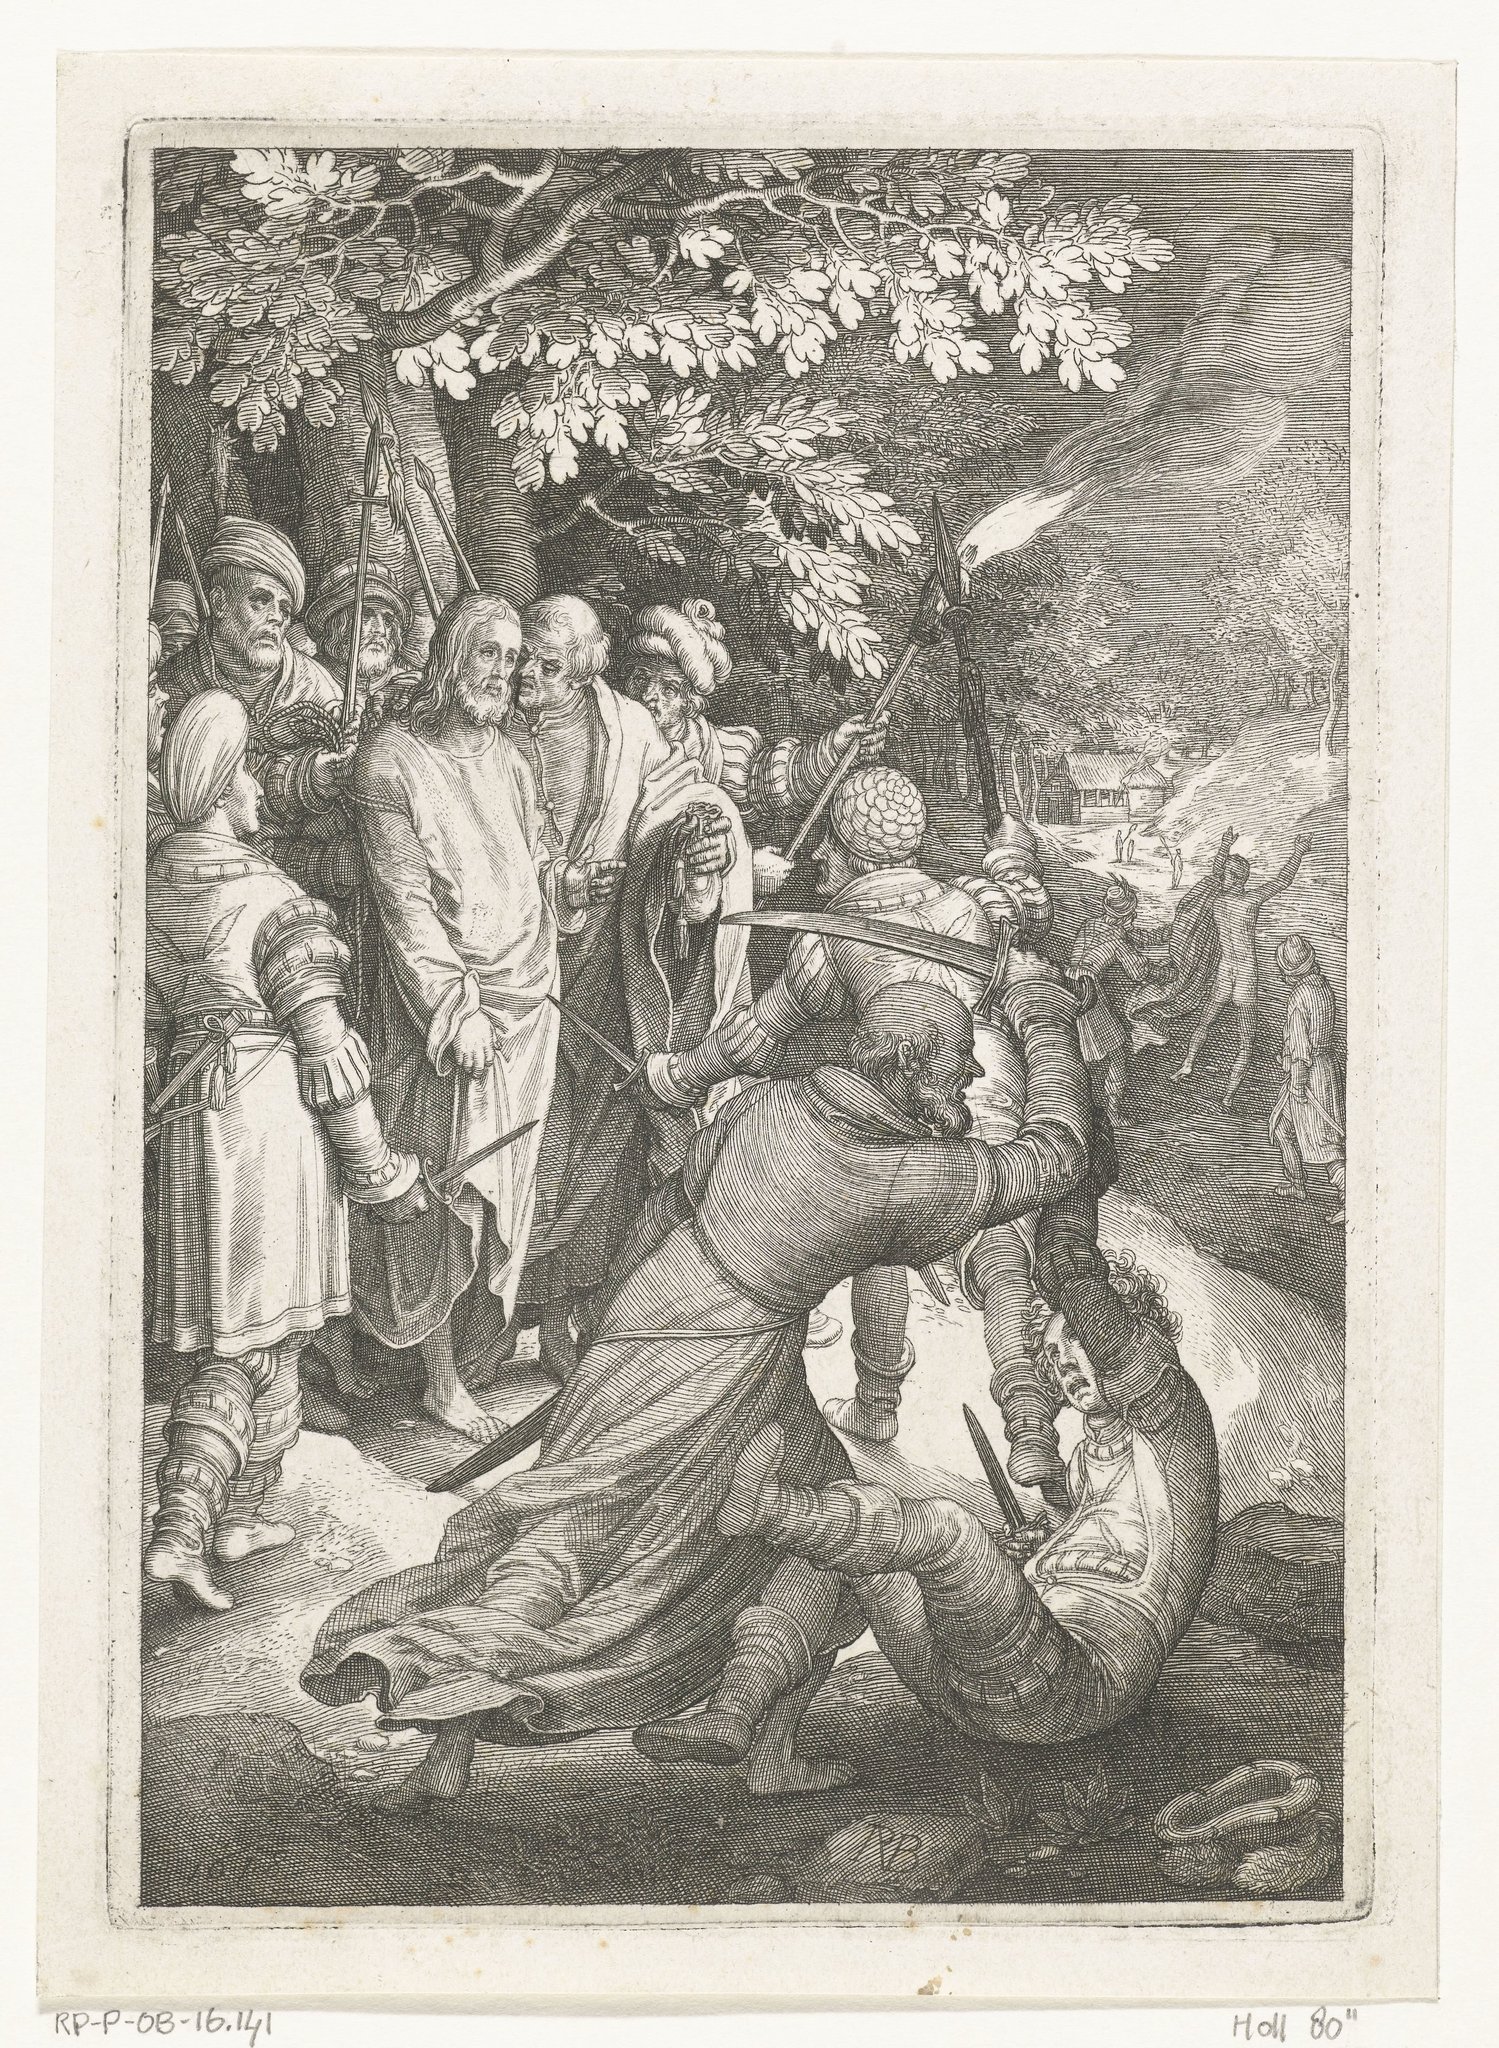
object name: print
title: Gevangenneming van Christus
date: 1618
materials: paper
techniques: engraving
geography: netherlands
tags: the arrest of christ ~ garden of gethsemane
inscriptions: collector's mark: Lugt 2228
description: Christus wordt gevangen genomen door soldaten als Judas hem met een kus verraadt. Op de voorgrond heft Simon Petrus zijn zwaard om het oor af te hakken van de slaaf van de hogepriester.